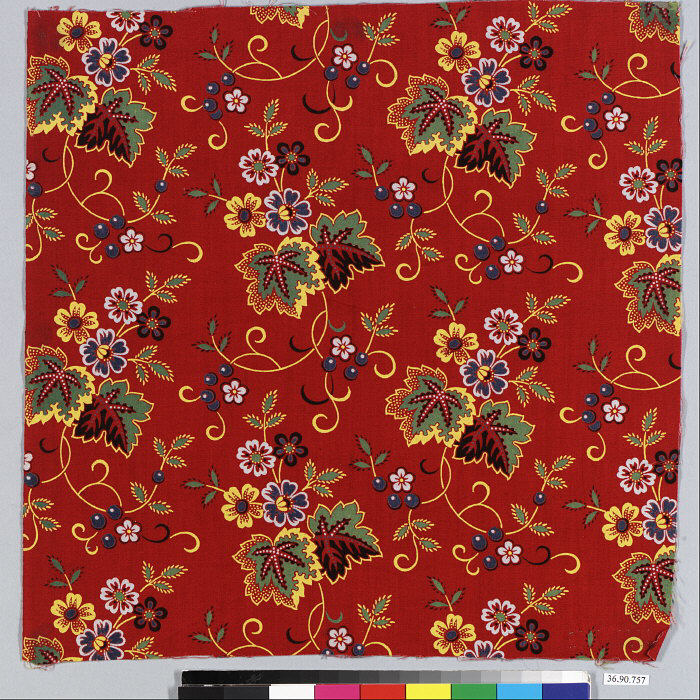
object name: piece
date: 1867-1900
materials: cotton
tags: flowers,leaves